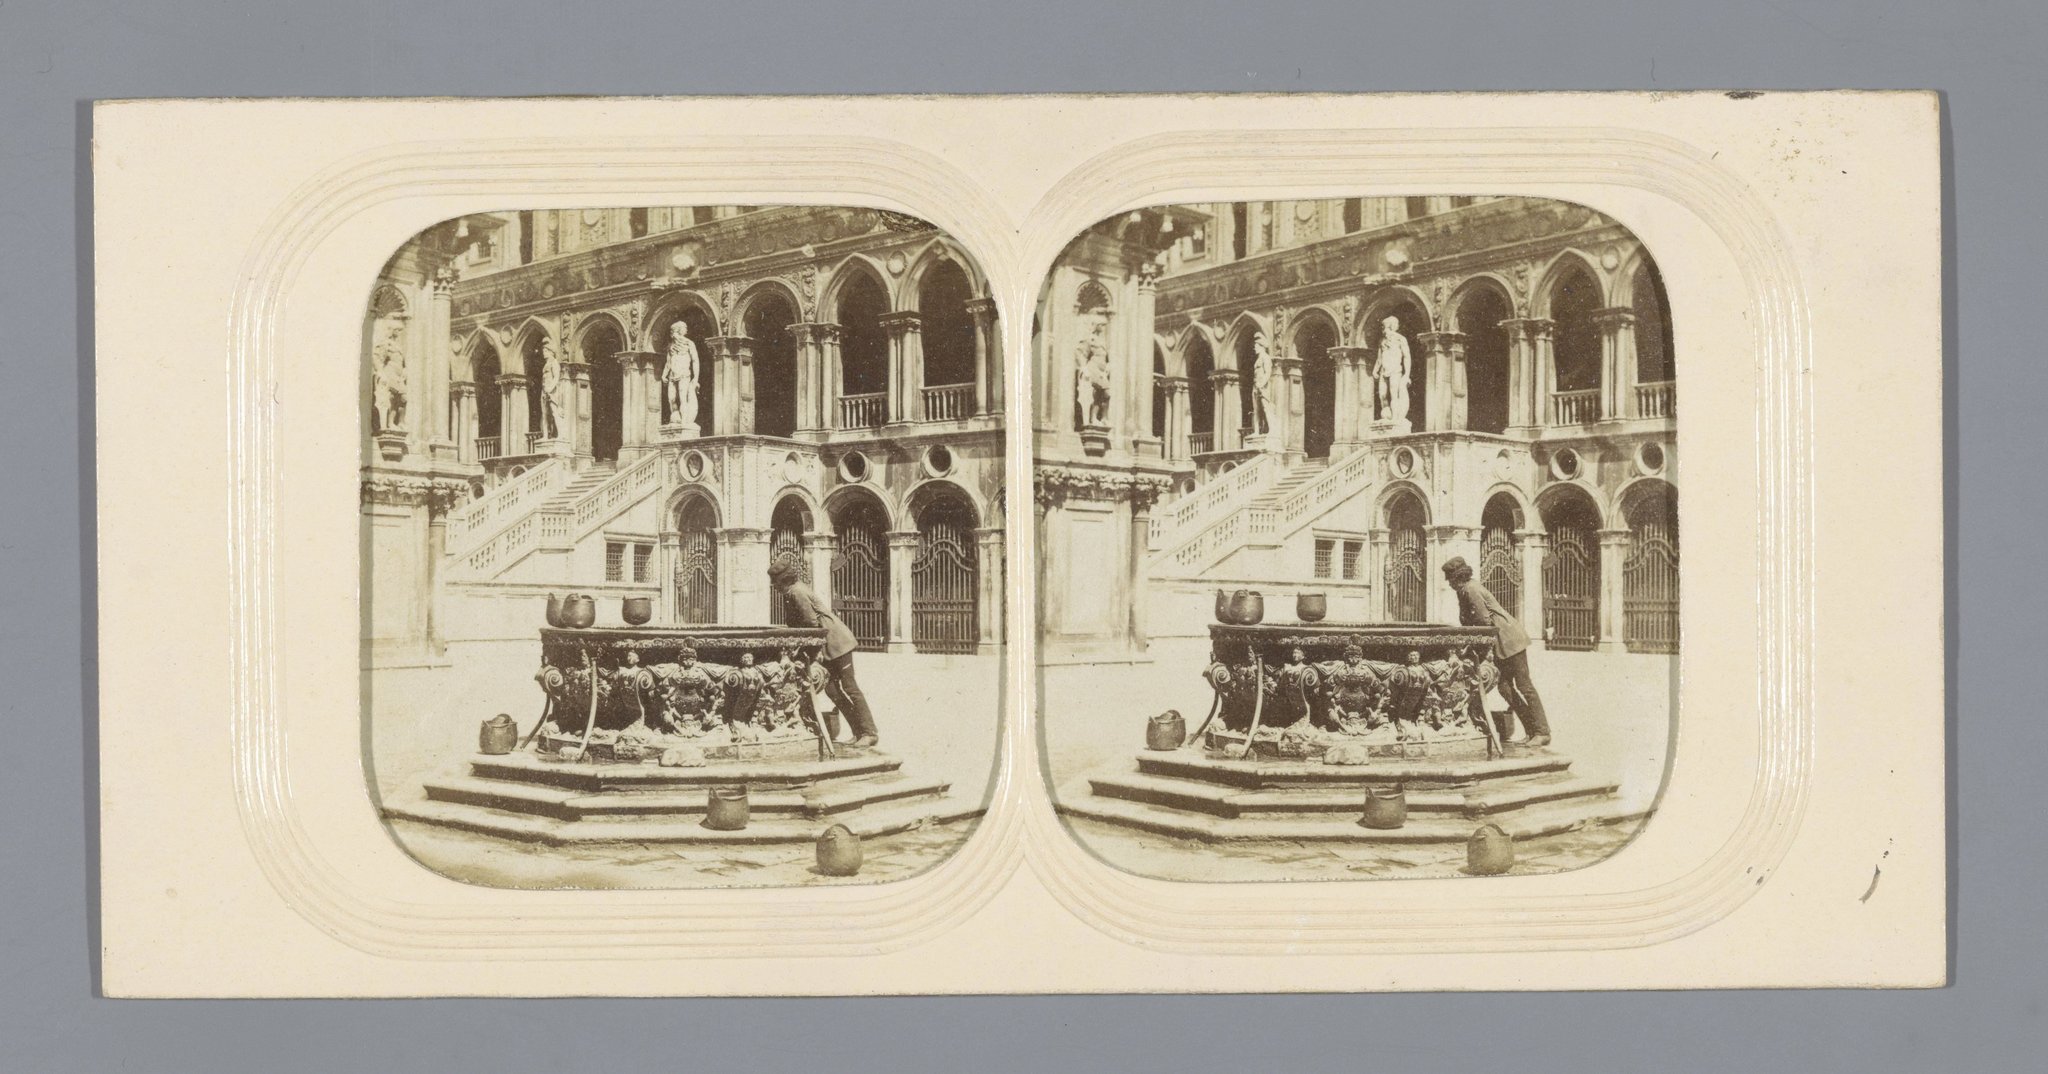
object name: tissue stereograph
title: Scala dei Giganti op de binnenplaats van het Dogepaleis in Venetië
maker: Anonymous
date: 1855-1875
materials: cardboard, paper, photographic support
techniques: albumen print, hand coloring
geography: venice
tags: palace, staircase, inner court of palace or 'hôtel'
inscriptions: inscription: ‘f1- Een binnenplaats/ Paleis./ Venetië’, inscription: ‘f1-’